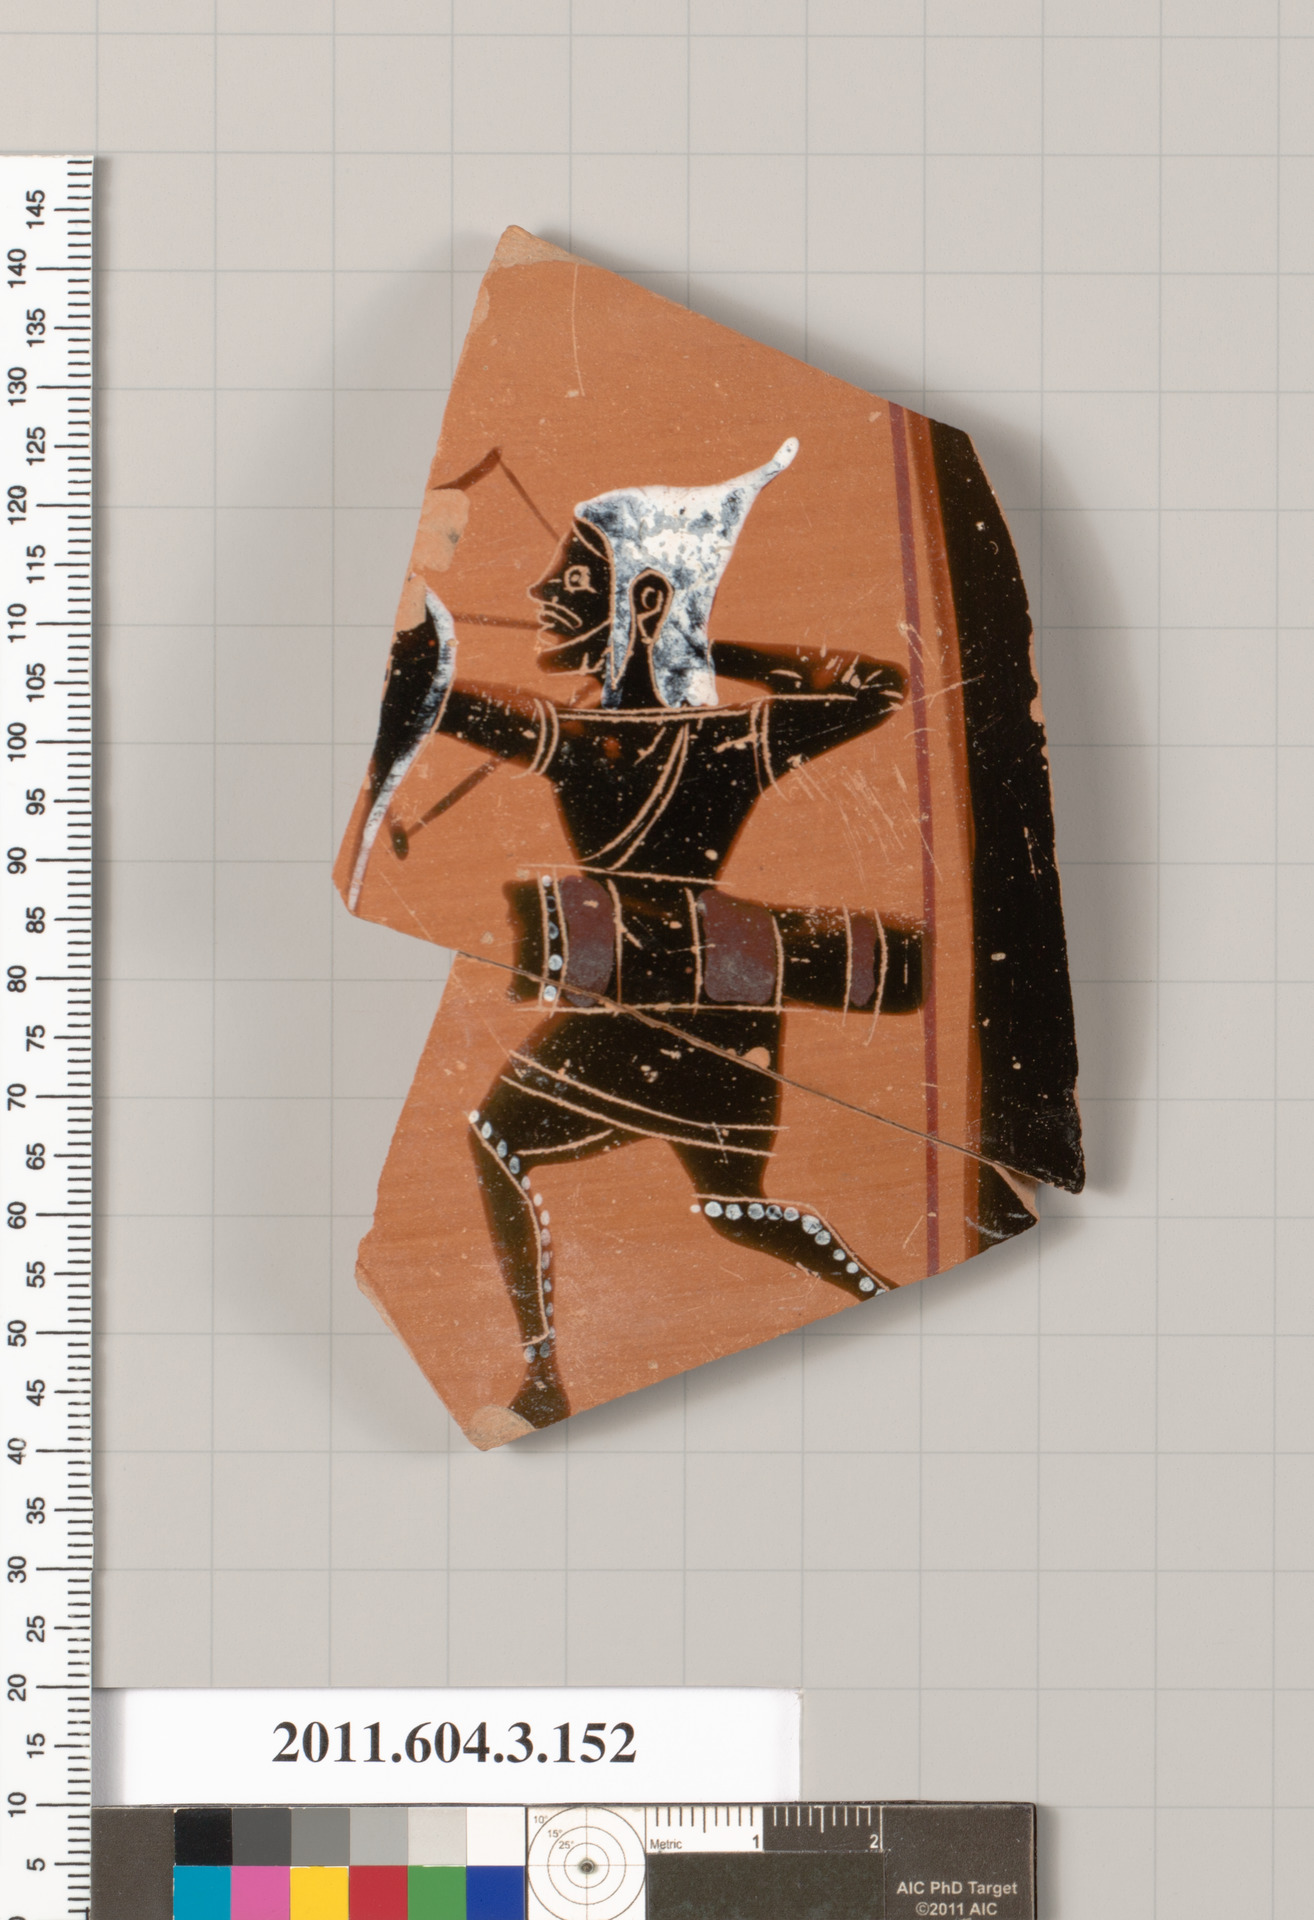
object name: amphora fragment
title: Terracotta fragment of an amphora (jar)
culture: greek, attic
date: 550-540 BCE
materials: terracotta